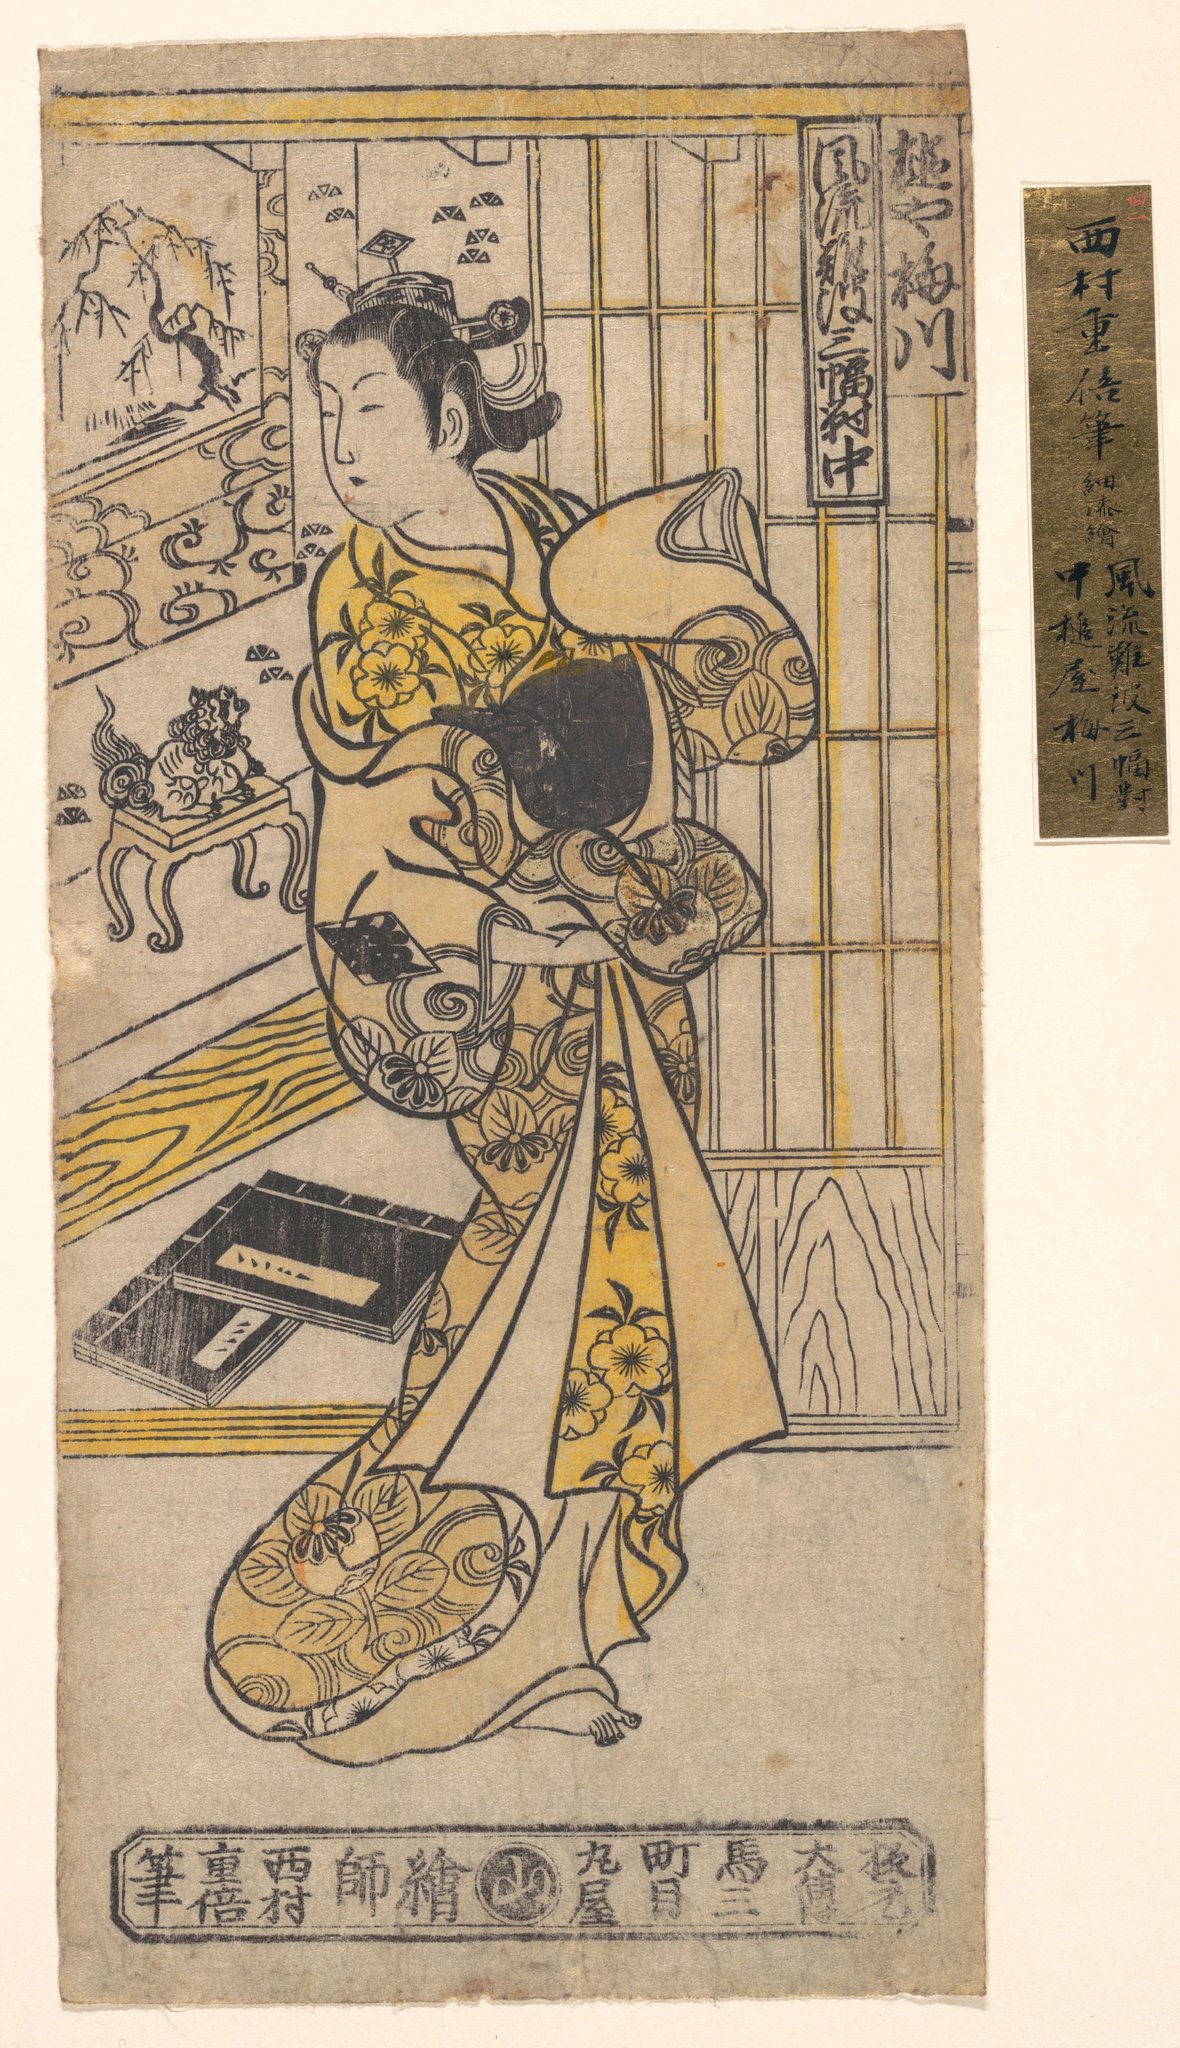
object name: print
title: The House of Umegawa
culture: japanese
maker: nishimura shigenobu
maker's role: artist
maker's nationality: japanese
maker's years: 1729-1739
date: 1615-1868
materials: ink, paper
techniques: woodblock print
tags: women